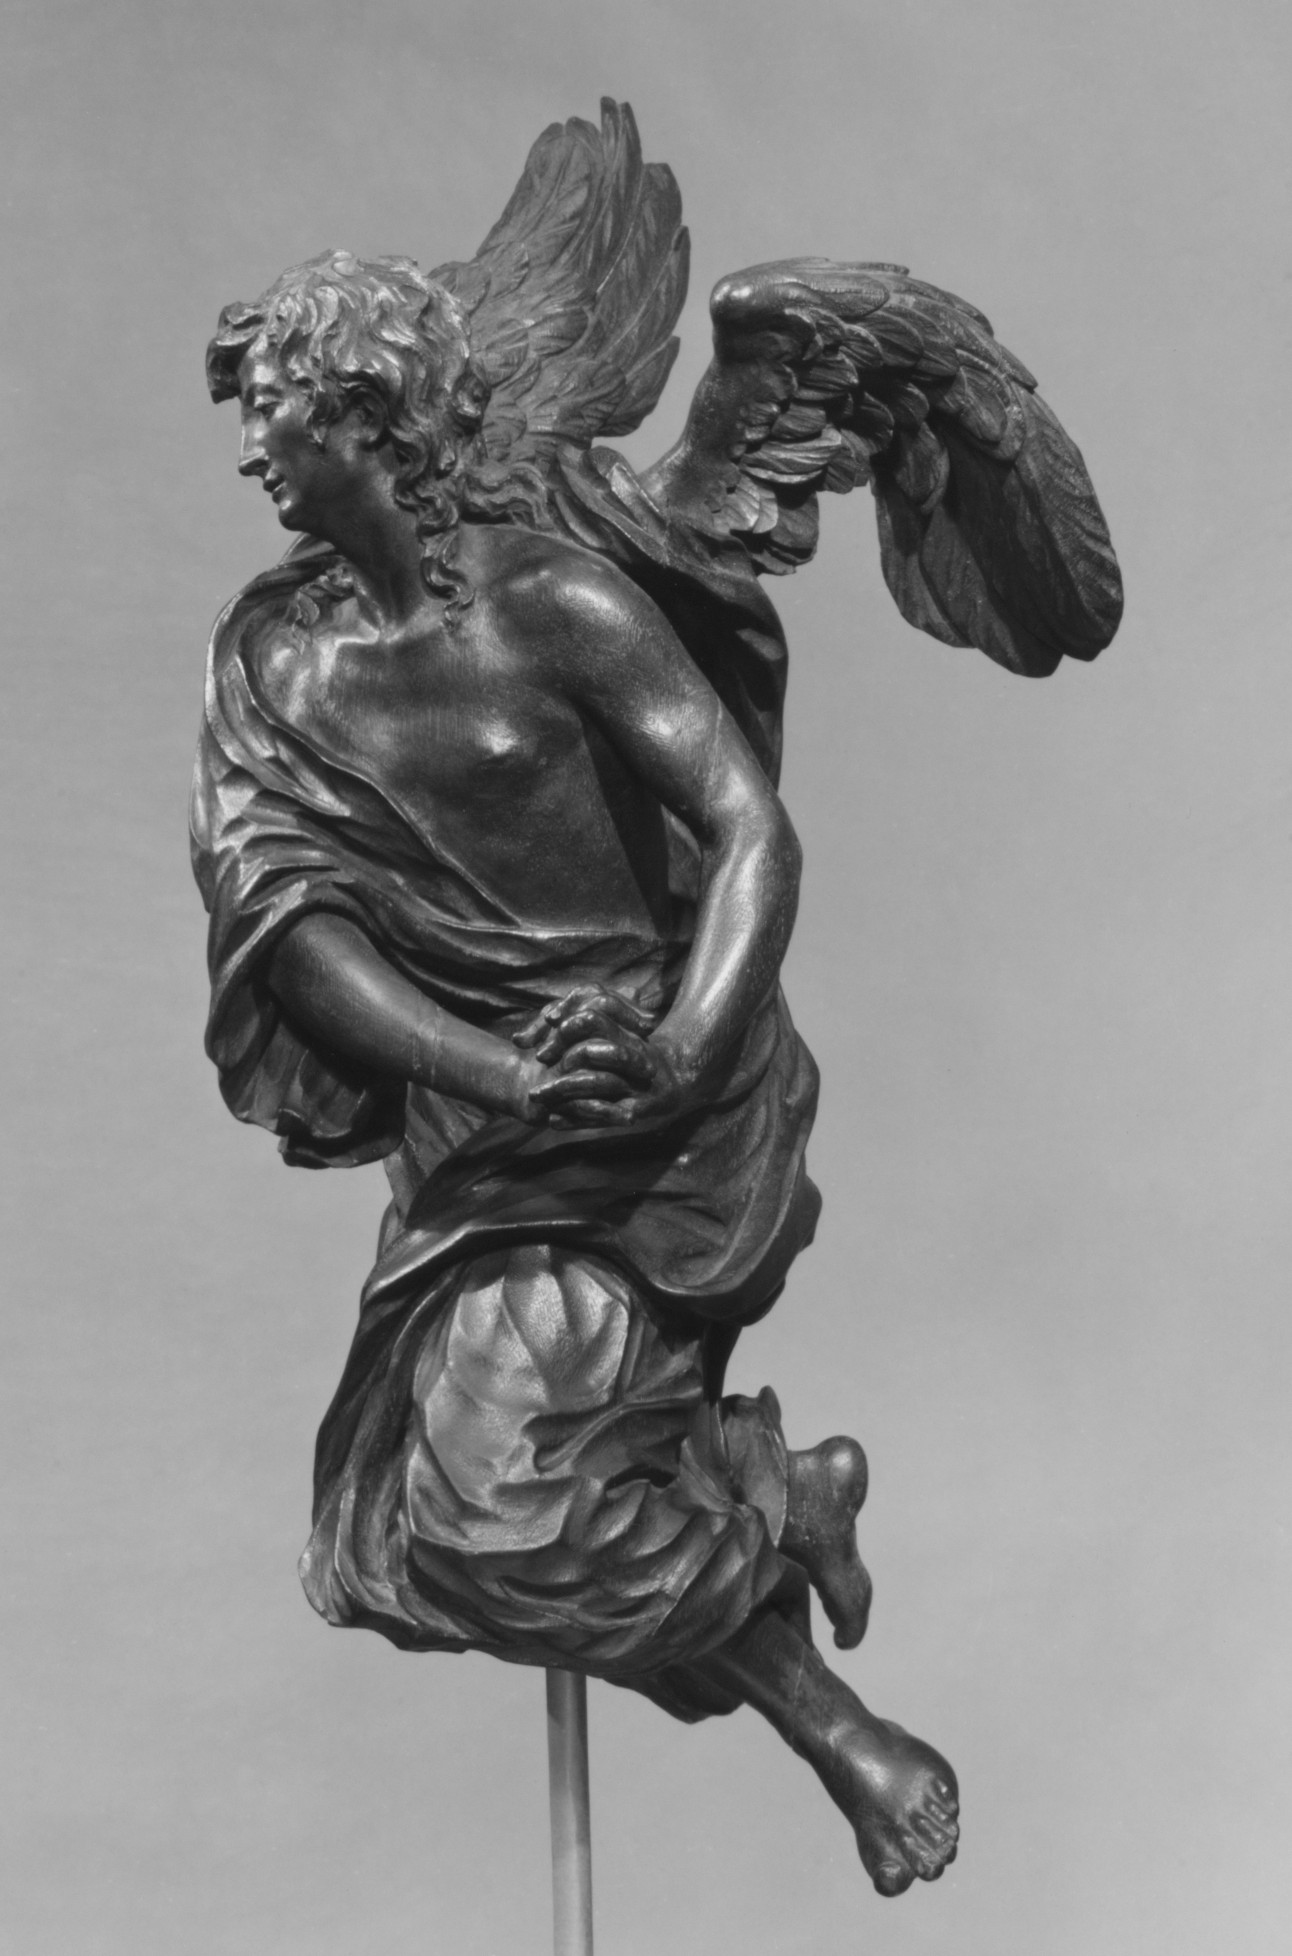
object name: angel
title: Angel (one of a pair)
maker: hendrik-frans verbruggen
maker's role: artist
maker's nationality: flemish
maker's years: 1654-1724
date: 1690-1710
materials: wood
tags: angels